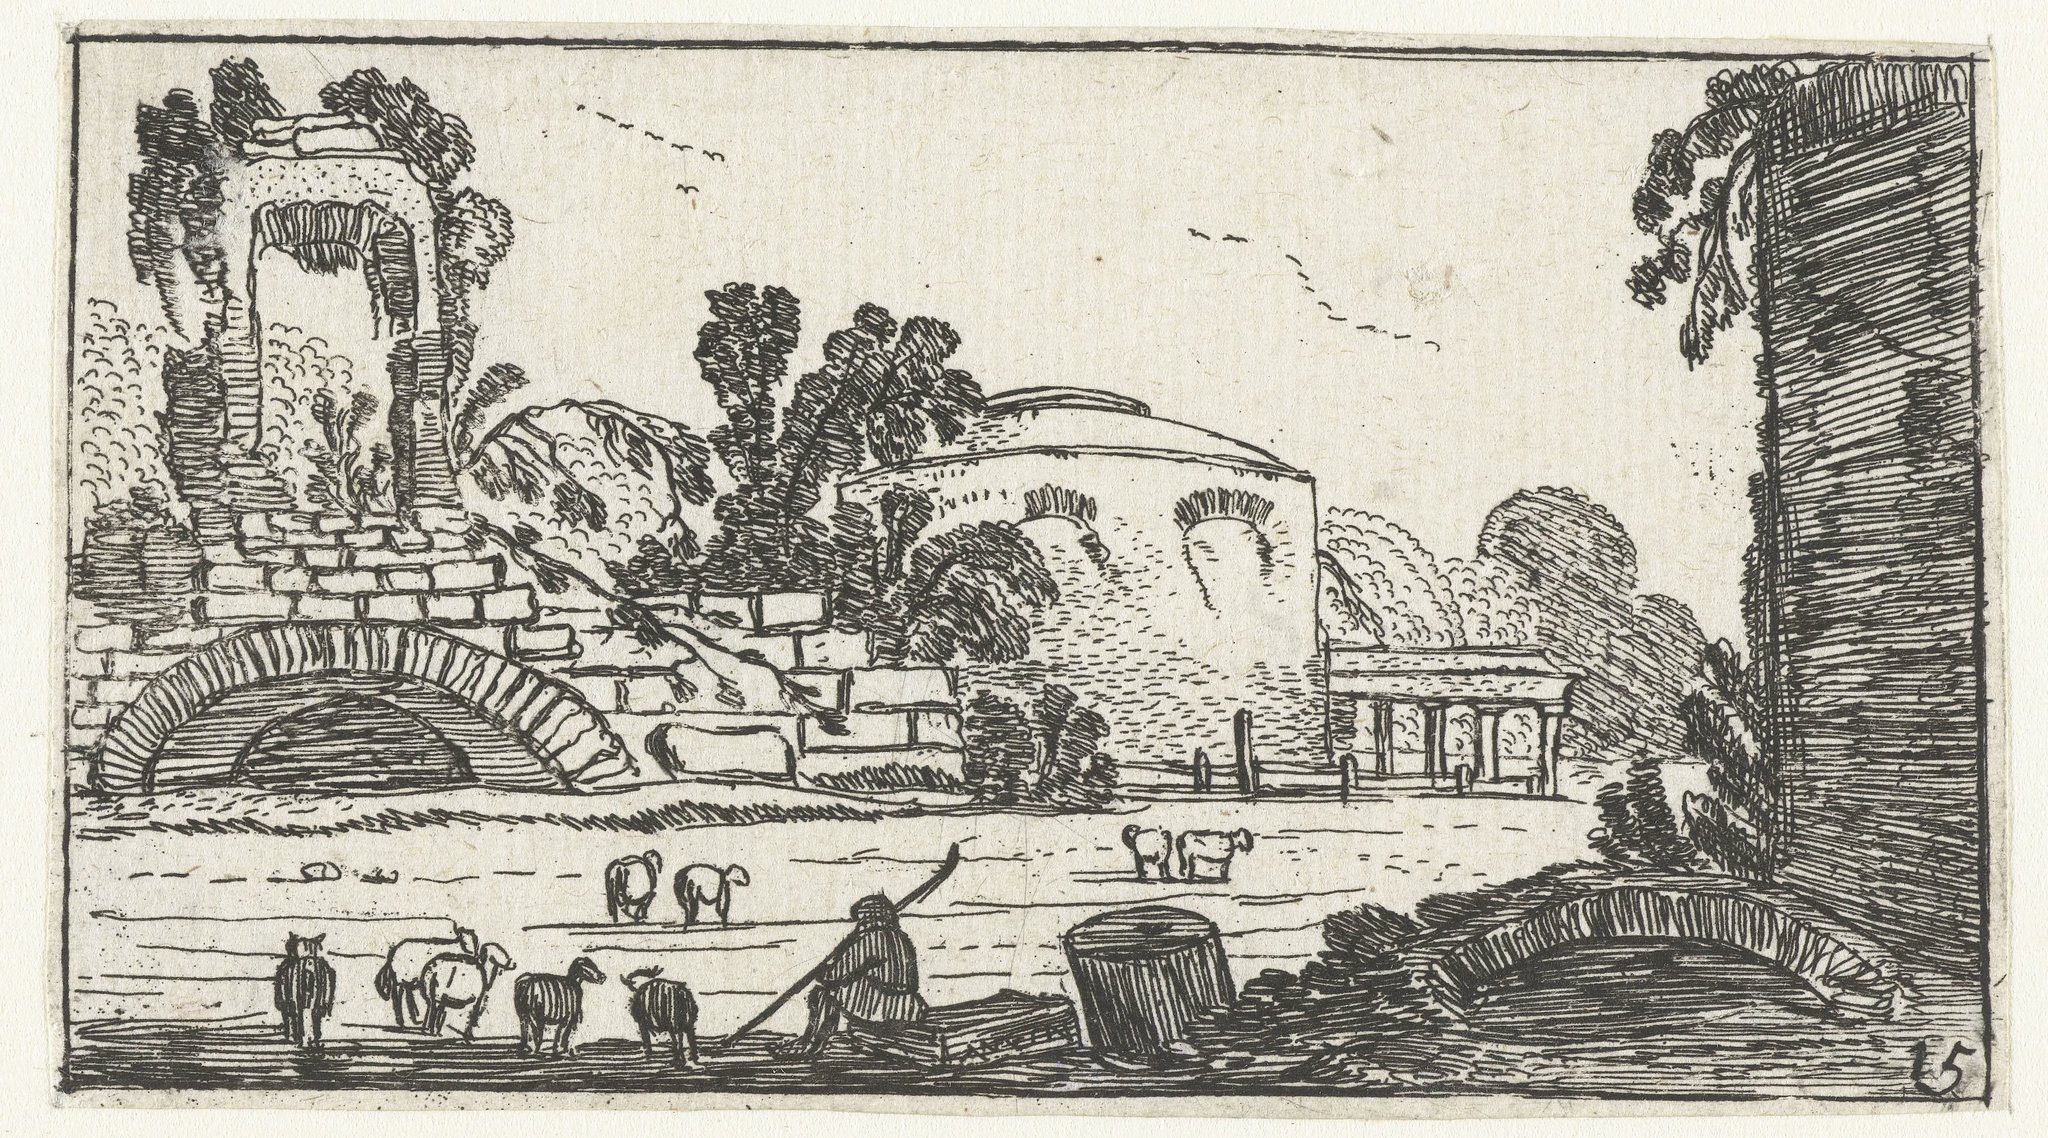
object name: print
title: Landschappen naar Esaias van de Velde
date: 1610-1617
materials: paper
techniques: etching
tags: landscape with ruins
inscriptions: collector's mark: Lugt 2227